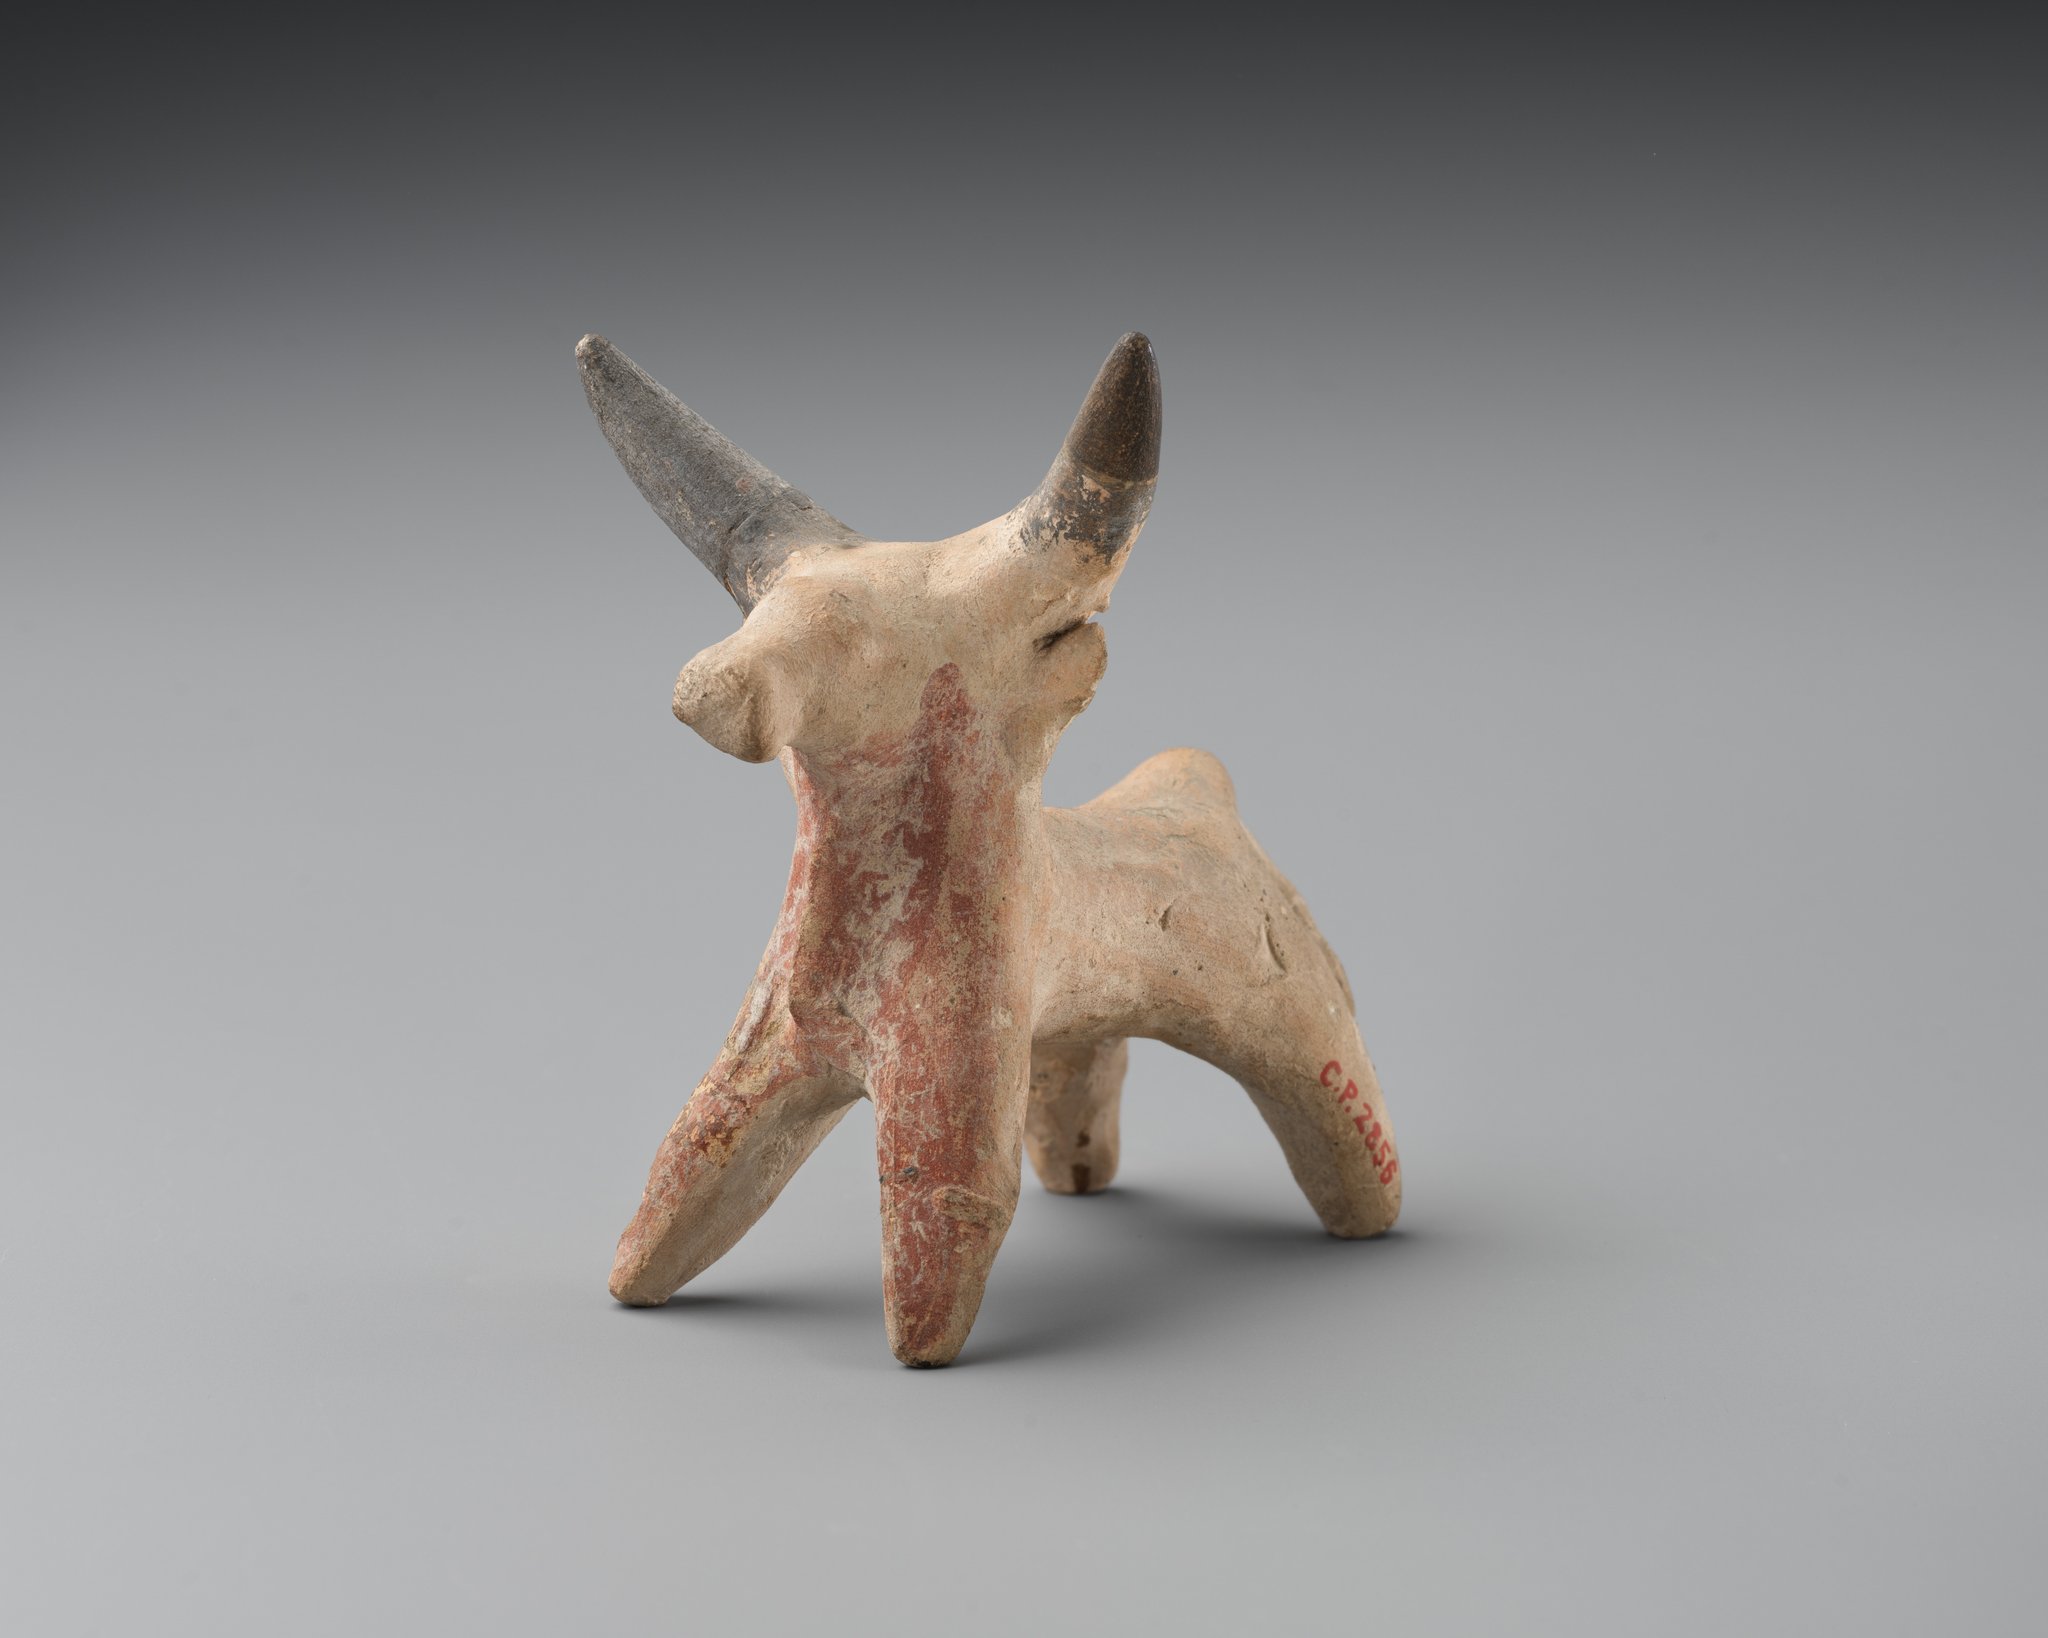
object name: statuette of a bull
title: Bull figurine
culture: cypriot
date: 600-480 BCE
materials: terracotta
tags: bulls